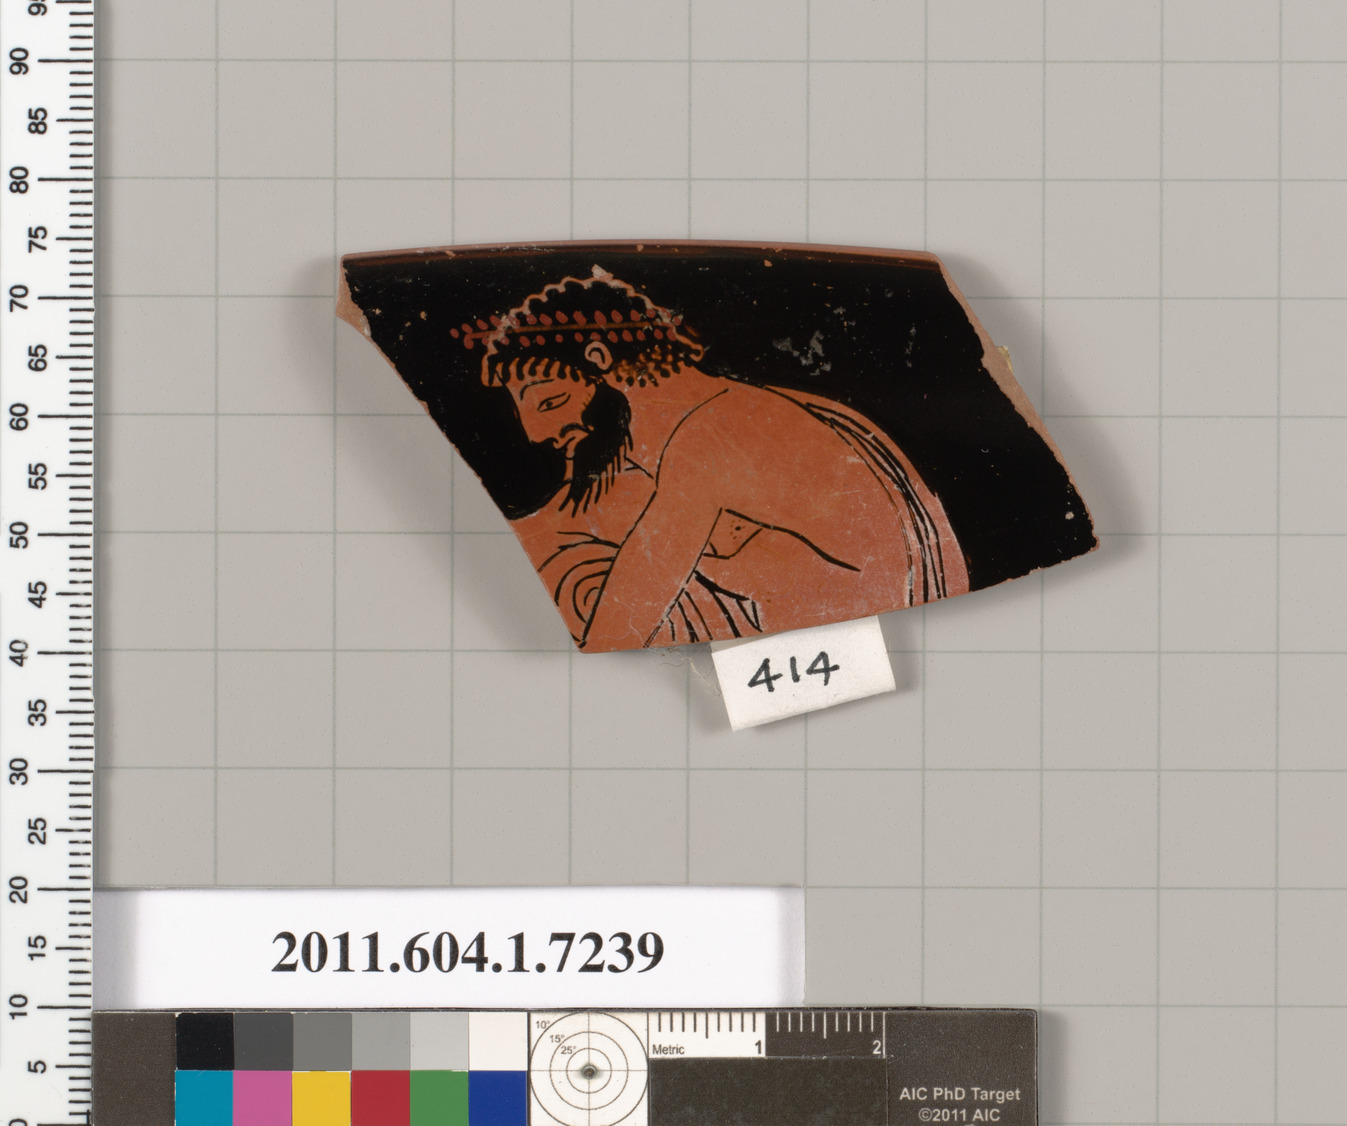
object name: kylix fragment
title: Terracotta rim fragment of a kylix (drinking cup)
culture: greek, attic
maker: makron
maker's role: artist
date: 500-480 BCE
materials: terracotta